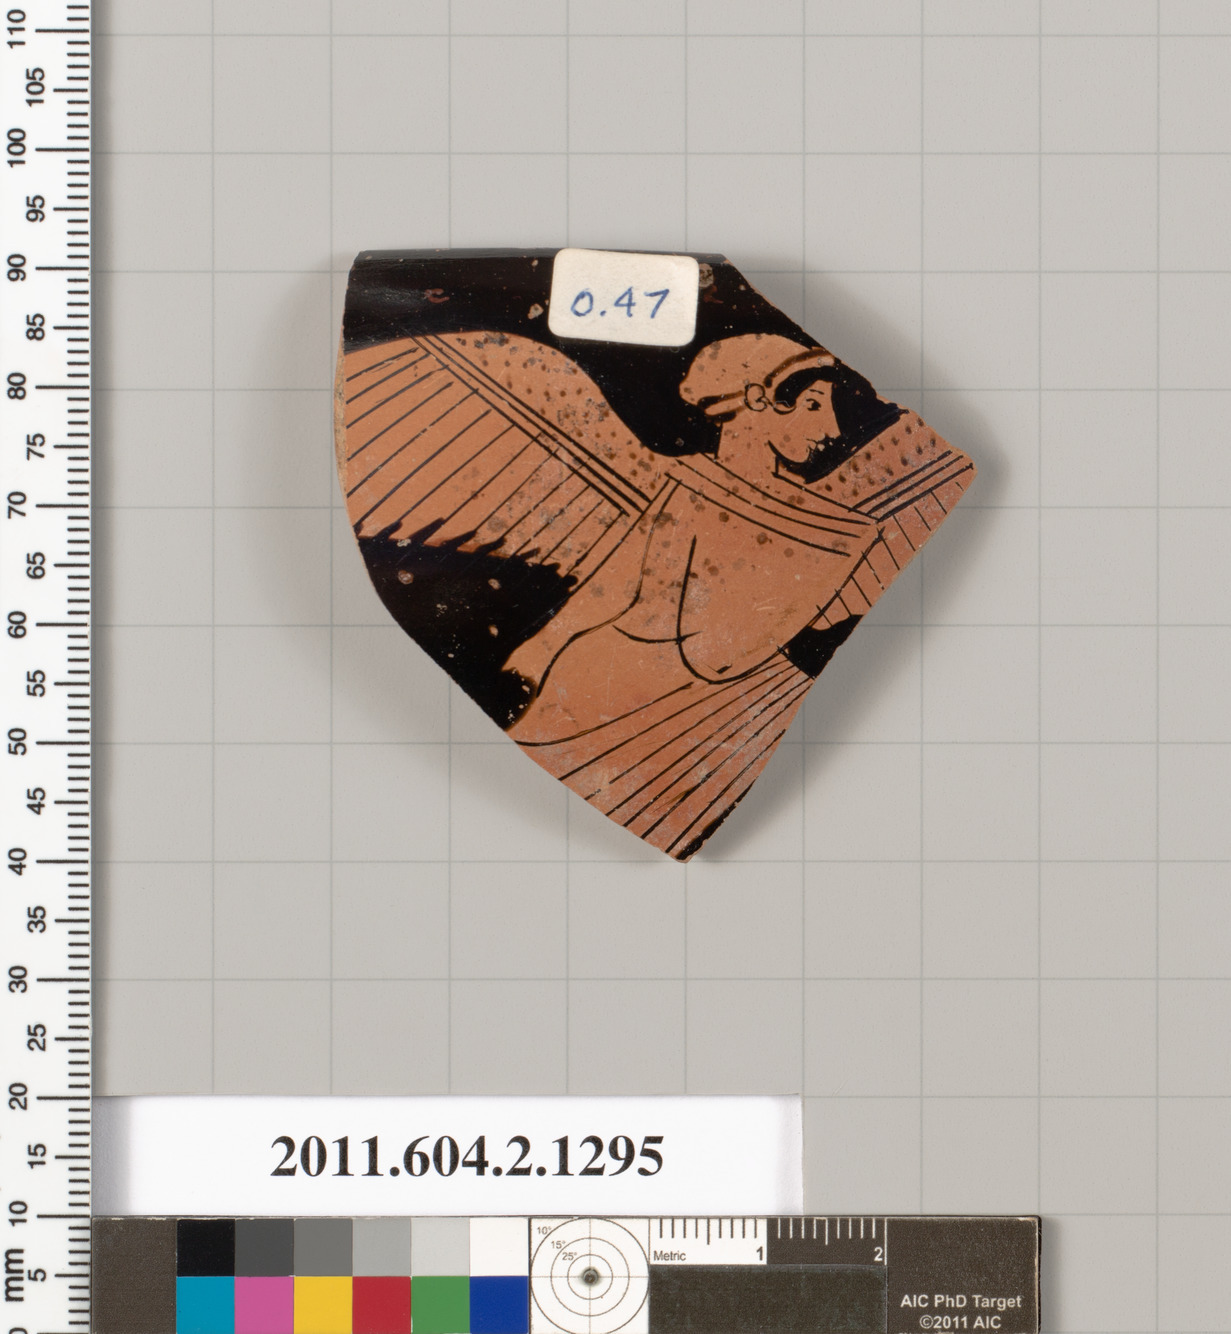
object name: skyphos fragment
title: Terracotta rim fragment of a skyphos (deep drinking cup)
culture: greek, attic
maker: dresden painter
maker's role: artist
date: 475-451 BCE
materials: terracotta